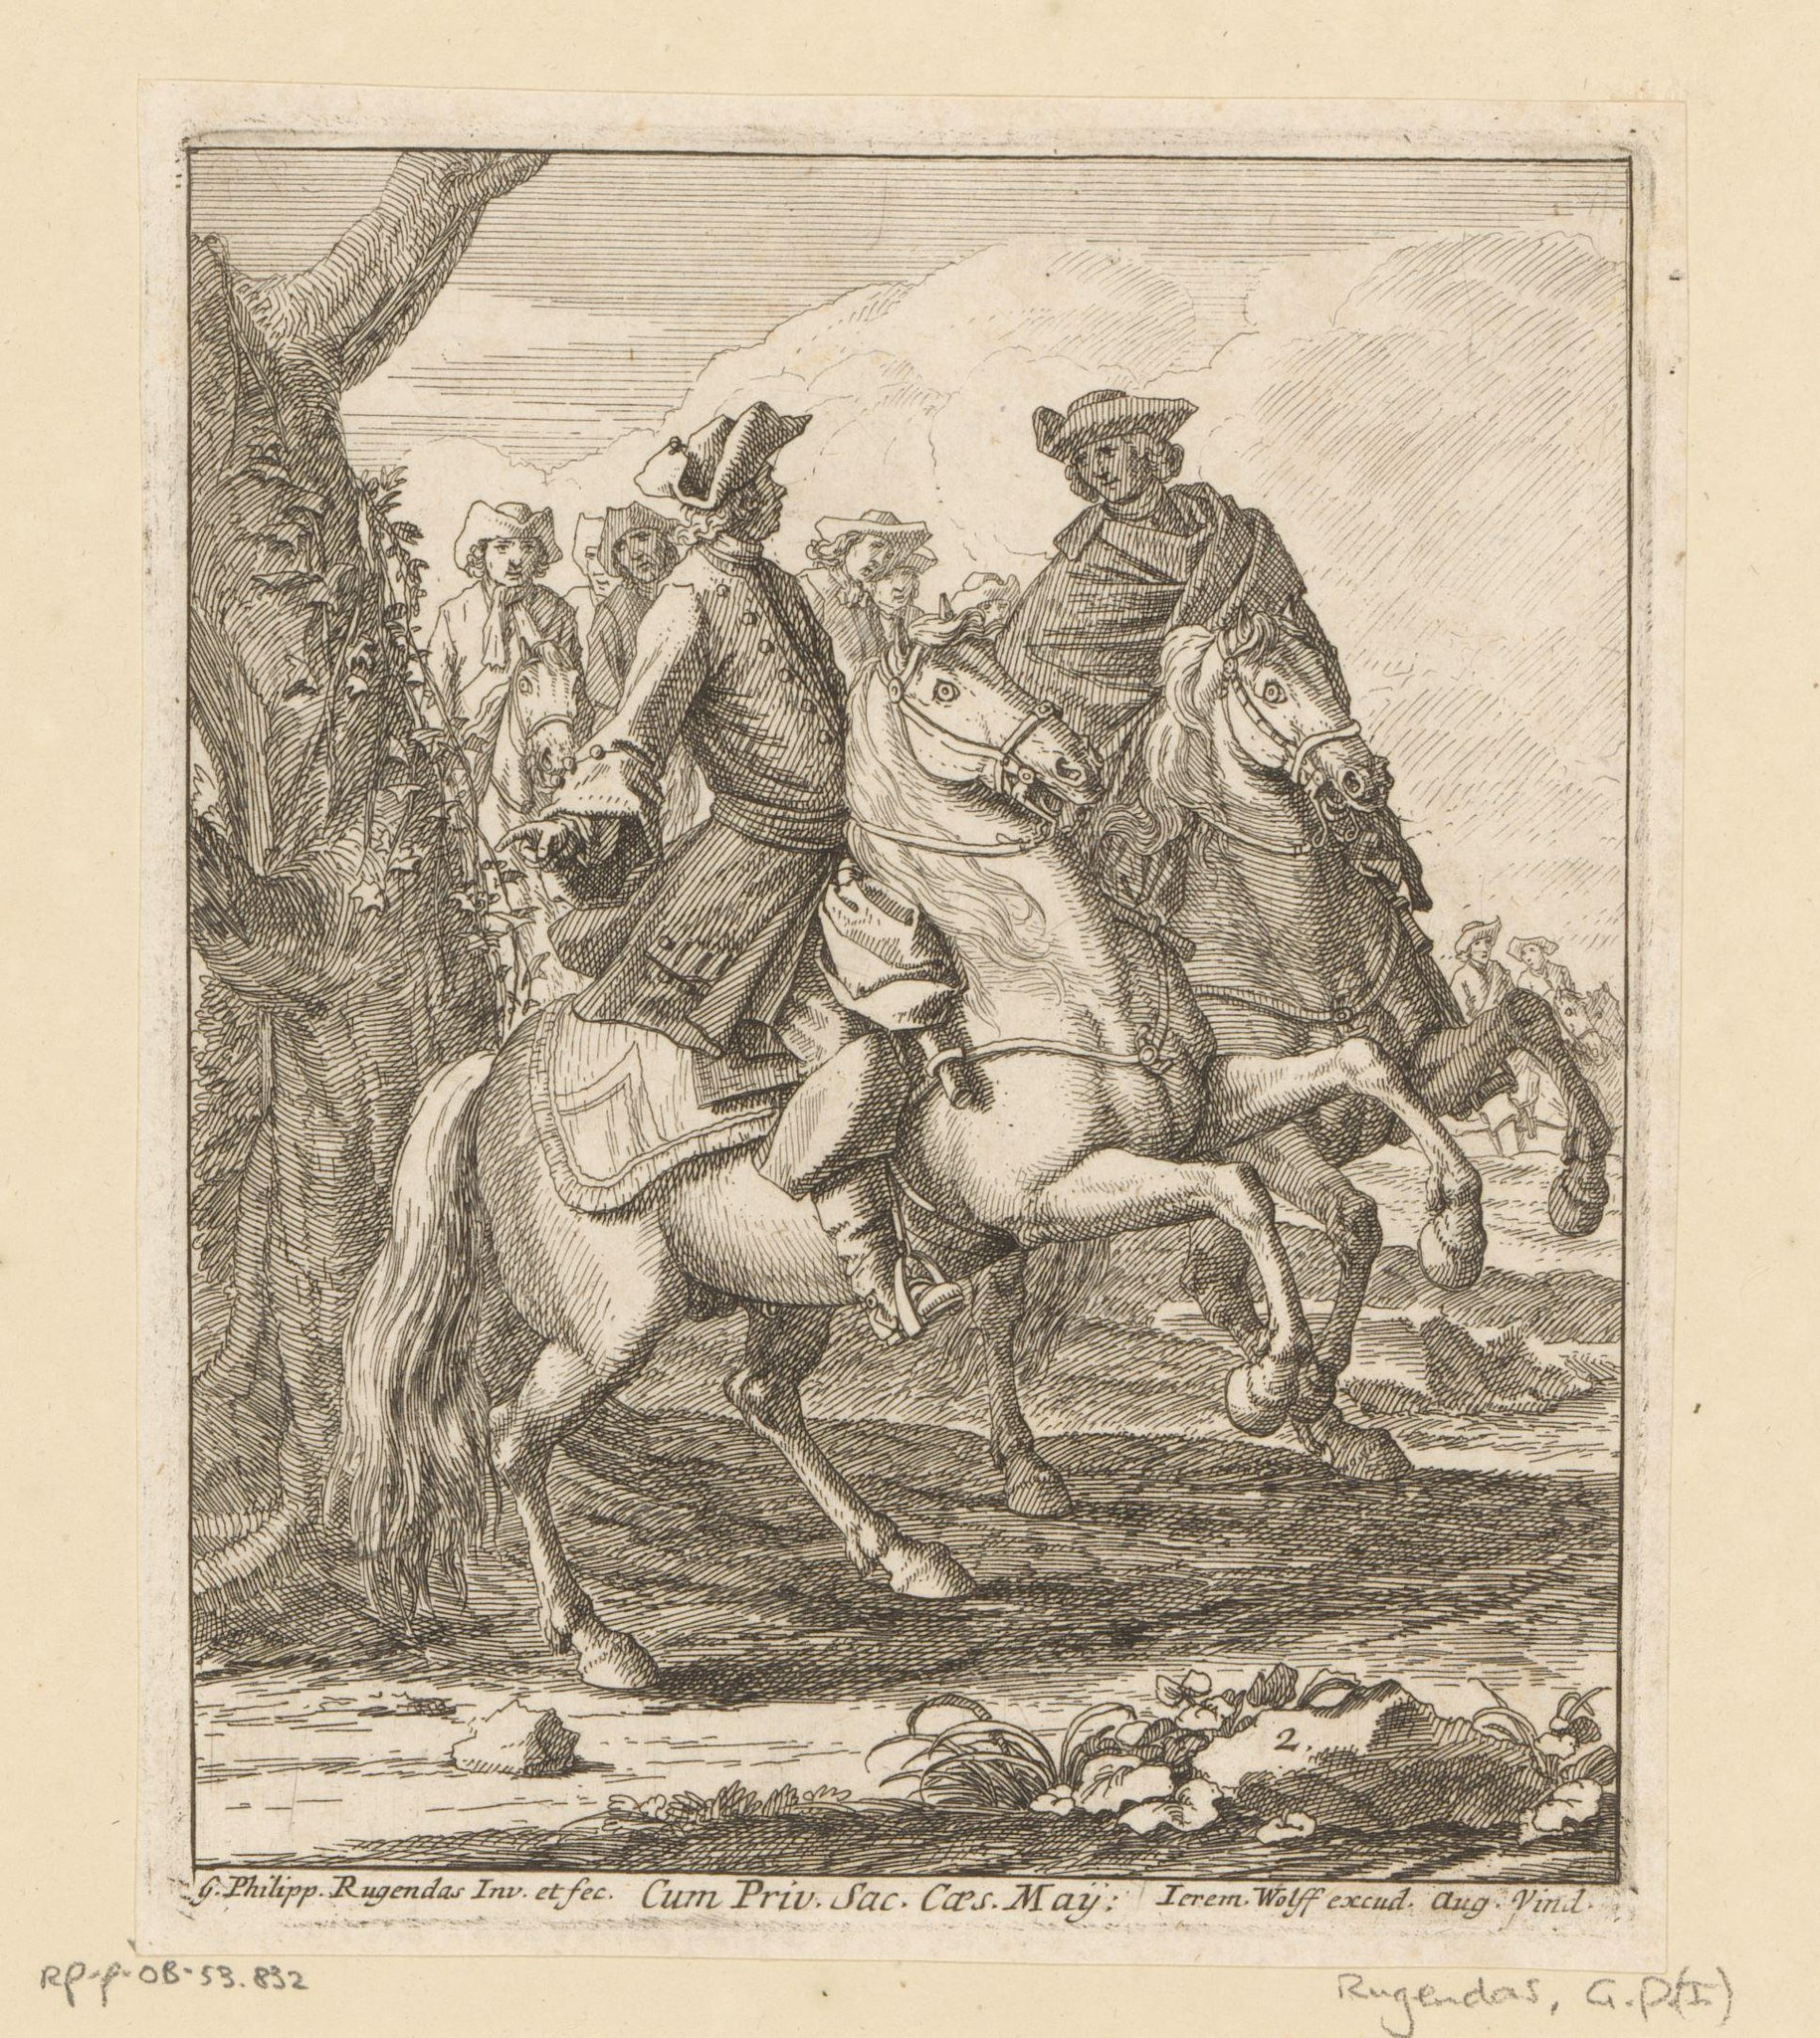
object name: print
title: Twee ruiters in gesprek bij een boom, achter hen meer ruiters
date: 1676-1742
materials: paper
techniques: etching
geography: augsburg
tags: riding a horse, ass, or mule; rider, horseman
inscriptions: collector's mark: Lugt 240